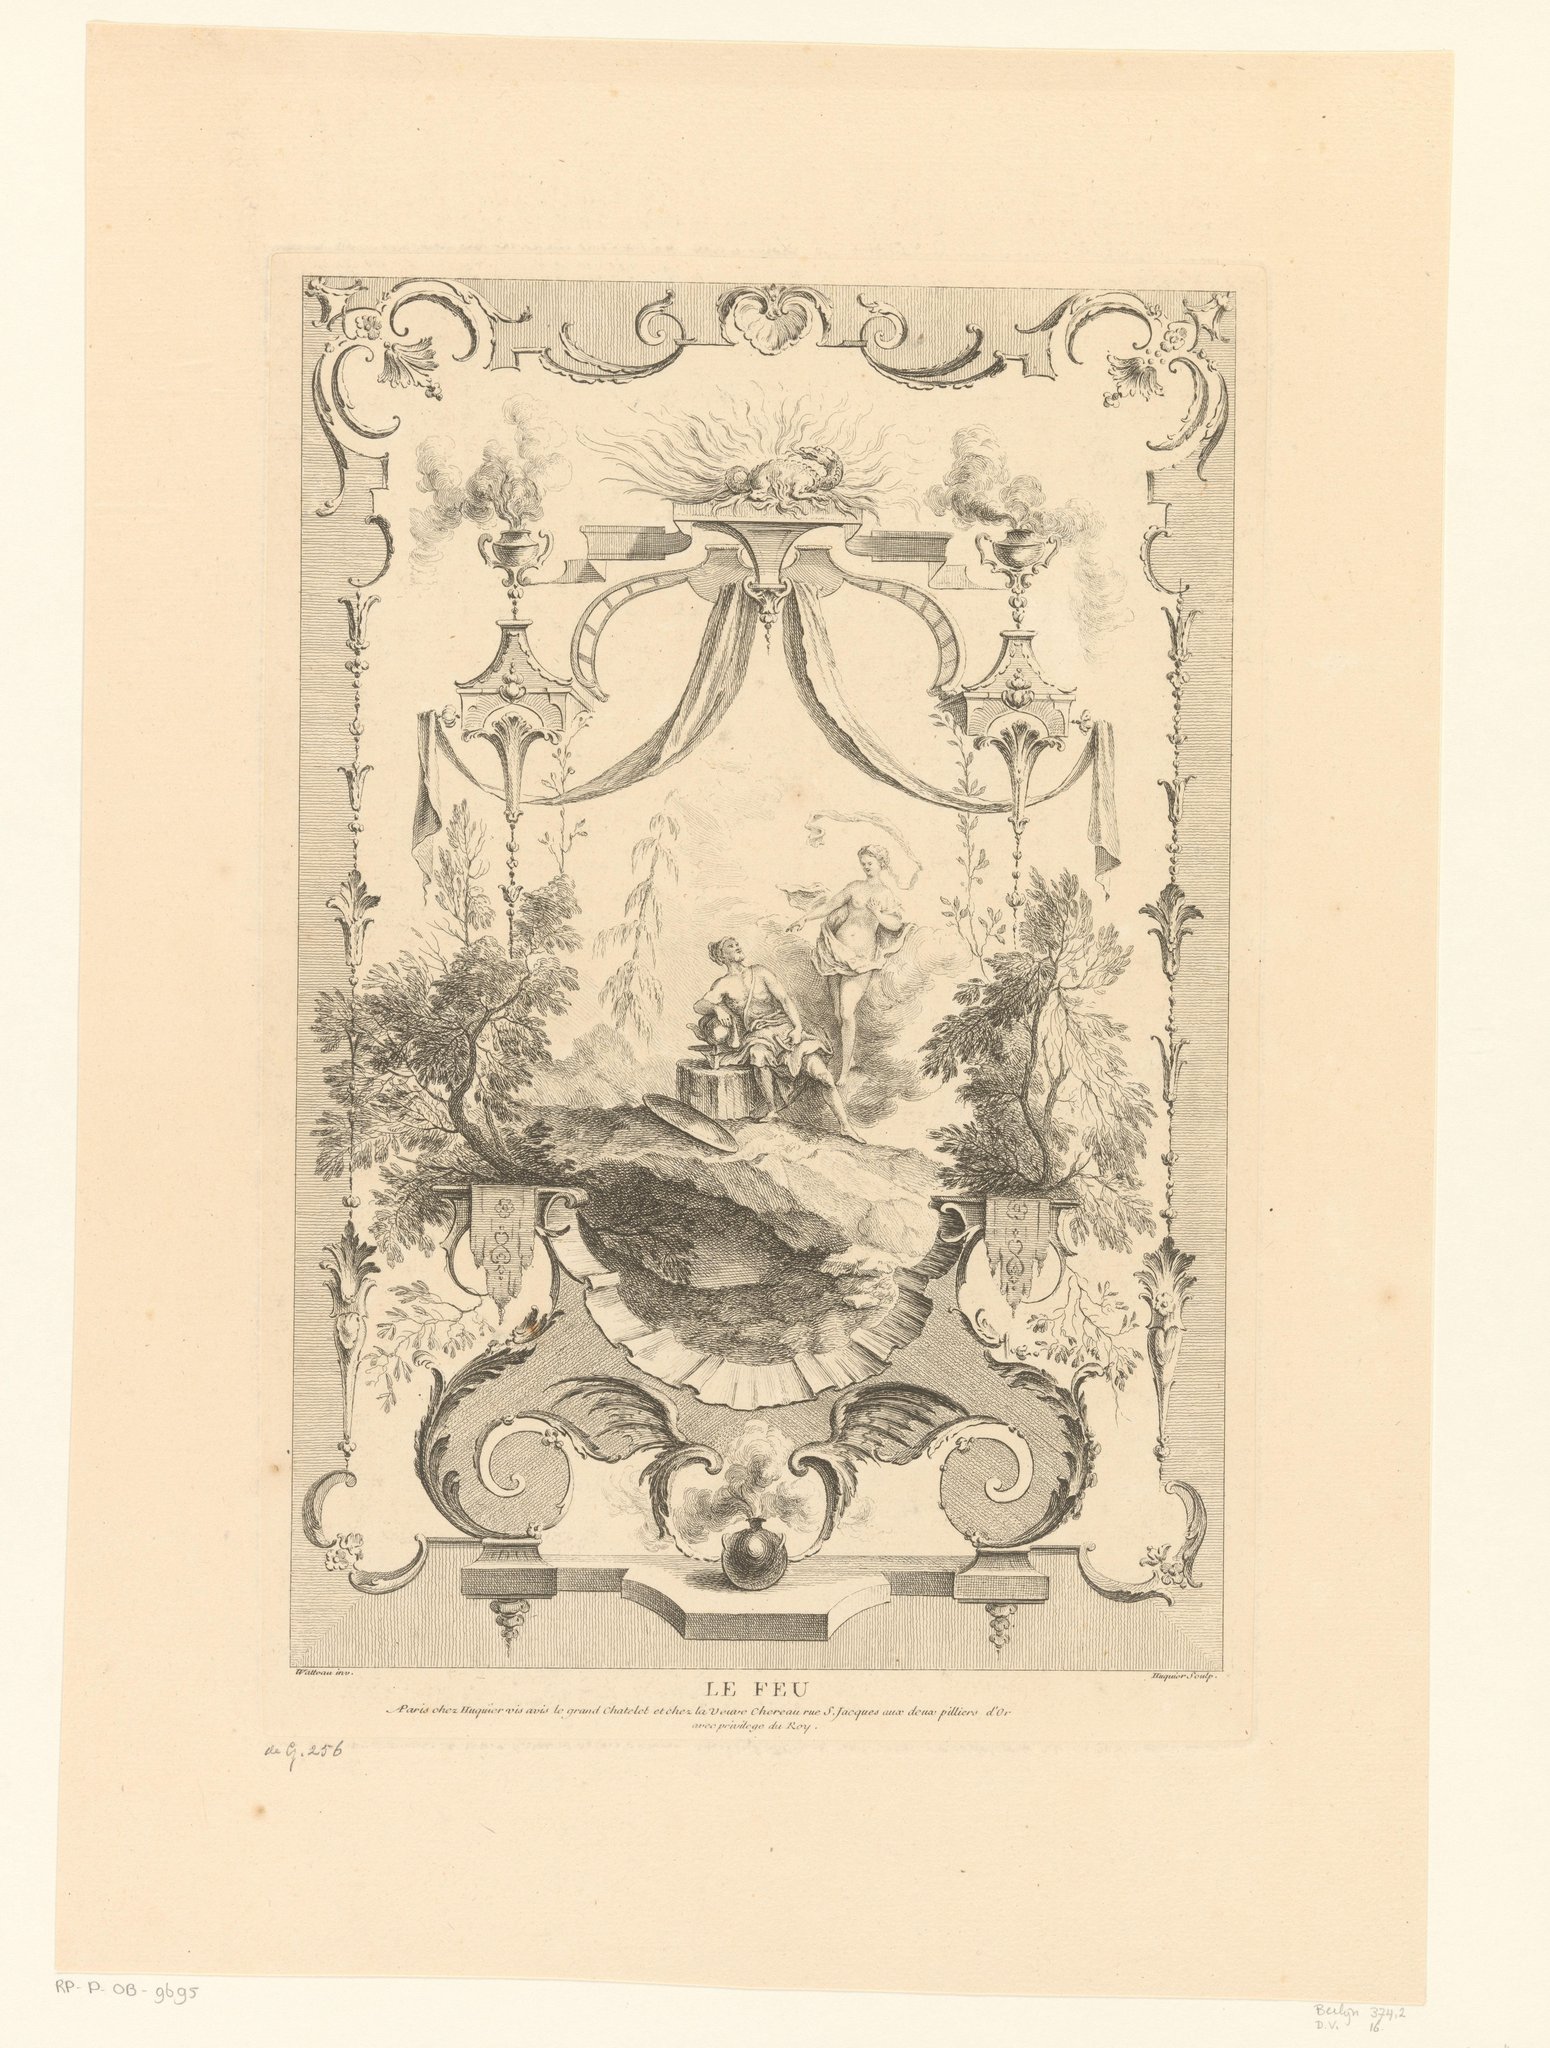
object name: print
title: Le Feu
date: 1729-1737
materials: paper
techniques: etching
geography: paris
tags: 'fuoco', 'carro del fuoco' (ripa)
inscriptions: collector's mark: Lugt 2228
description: Allegorie van het element vuur. In een landschap kijkt een vrouw op (rook)wolken naar een man leunend op een aambeeld. In zijn hand houdt hij een hamer. Rondom de voorstelling een omlijsting met rocailles, rookvaten, een draak omgeven door vuur en een rokende kanonskogel.